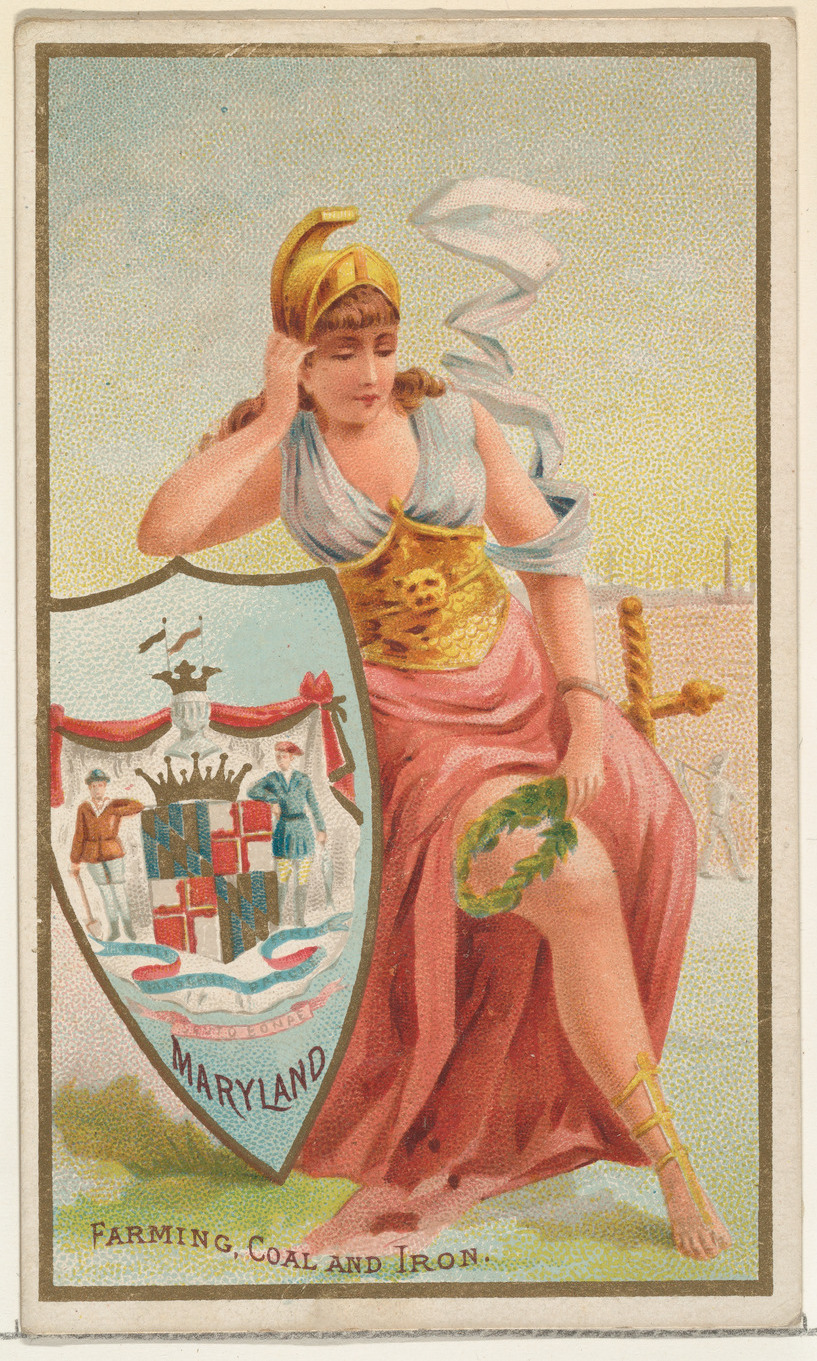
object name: print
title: Maryland, from the Industries of States series (N117) issued by Duke Sons & Co. to promote Honest Long Cut Tobacco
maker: w. duke, sons & co.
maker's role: publisher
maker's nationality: american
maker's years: 1870-1920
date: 1889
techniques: color lithograph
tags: shields,women